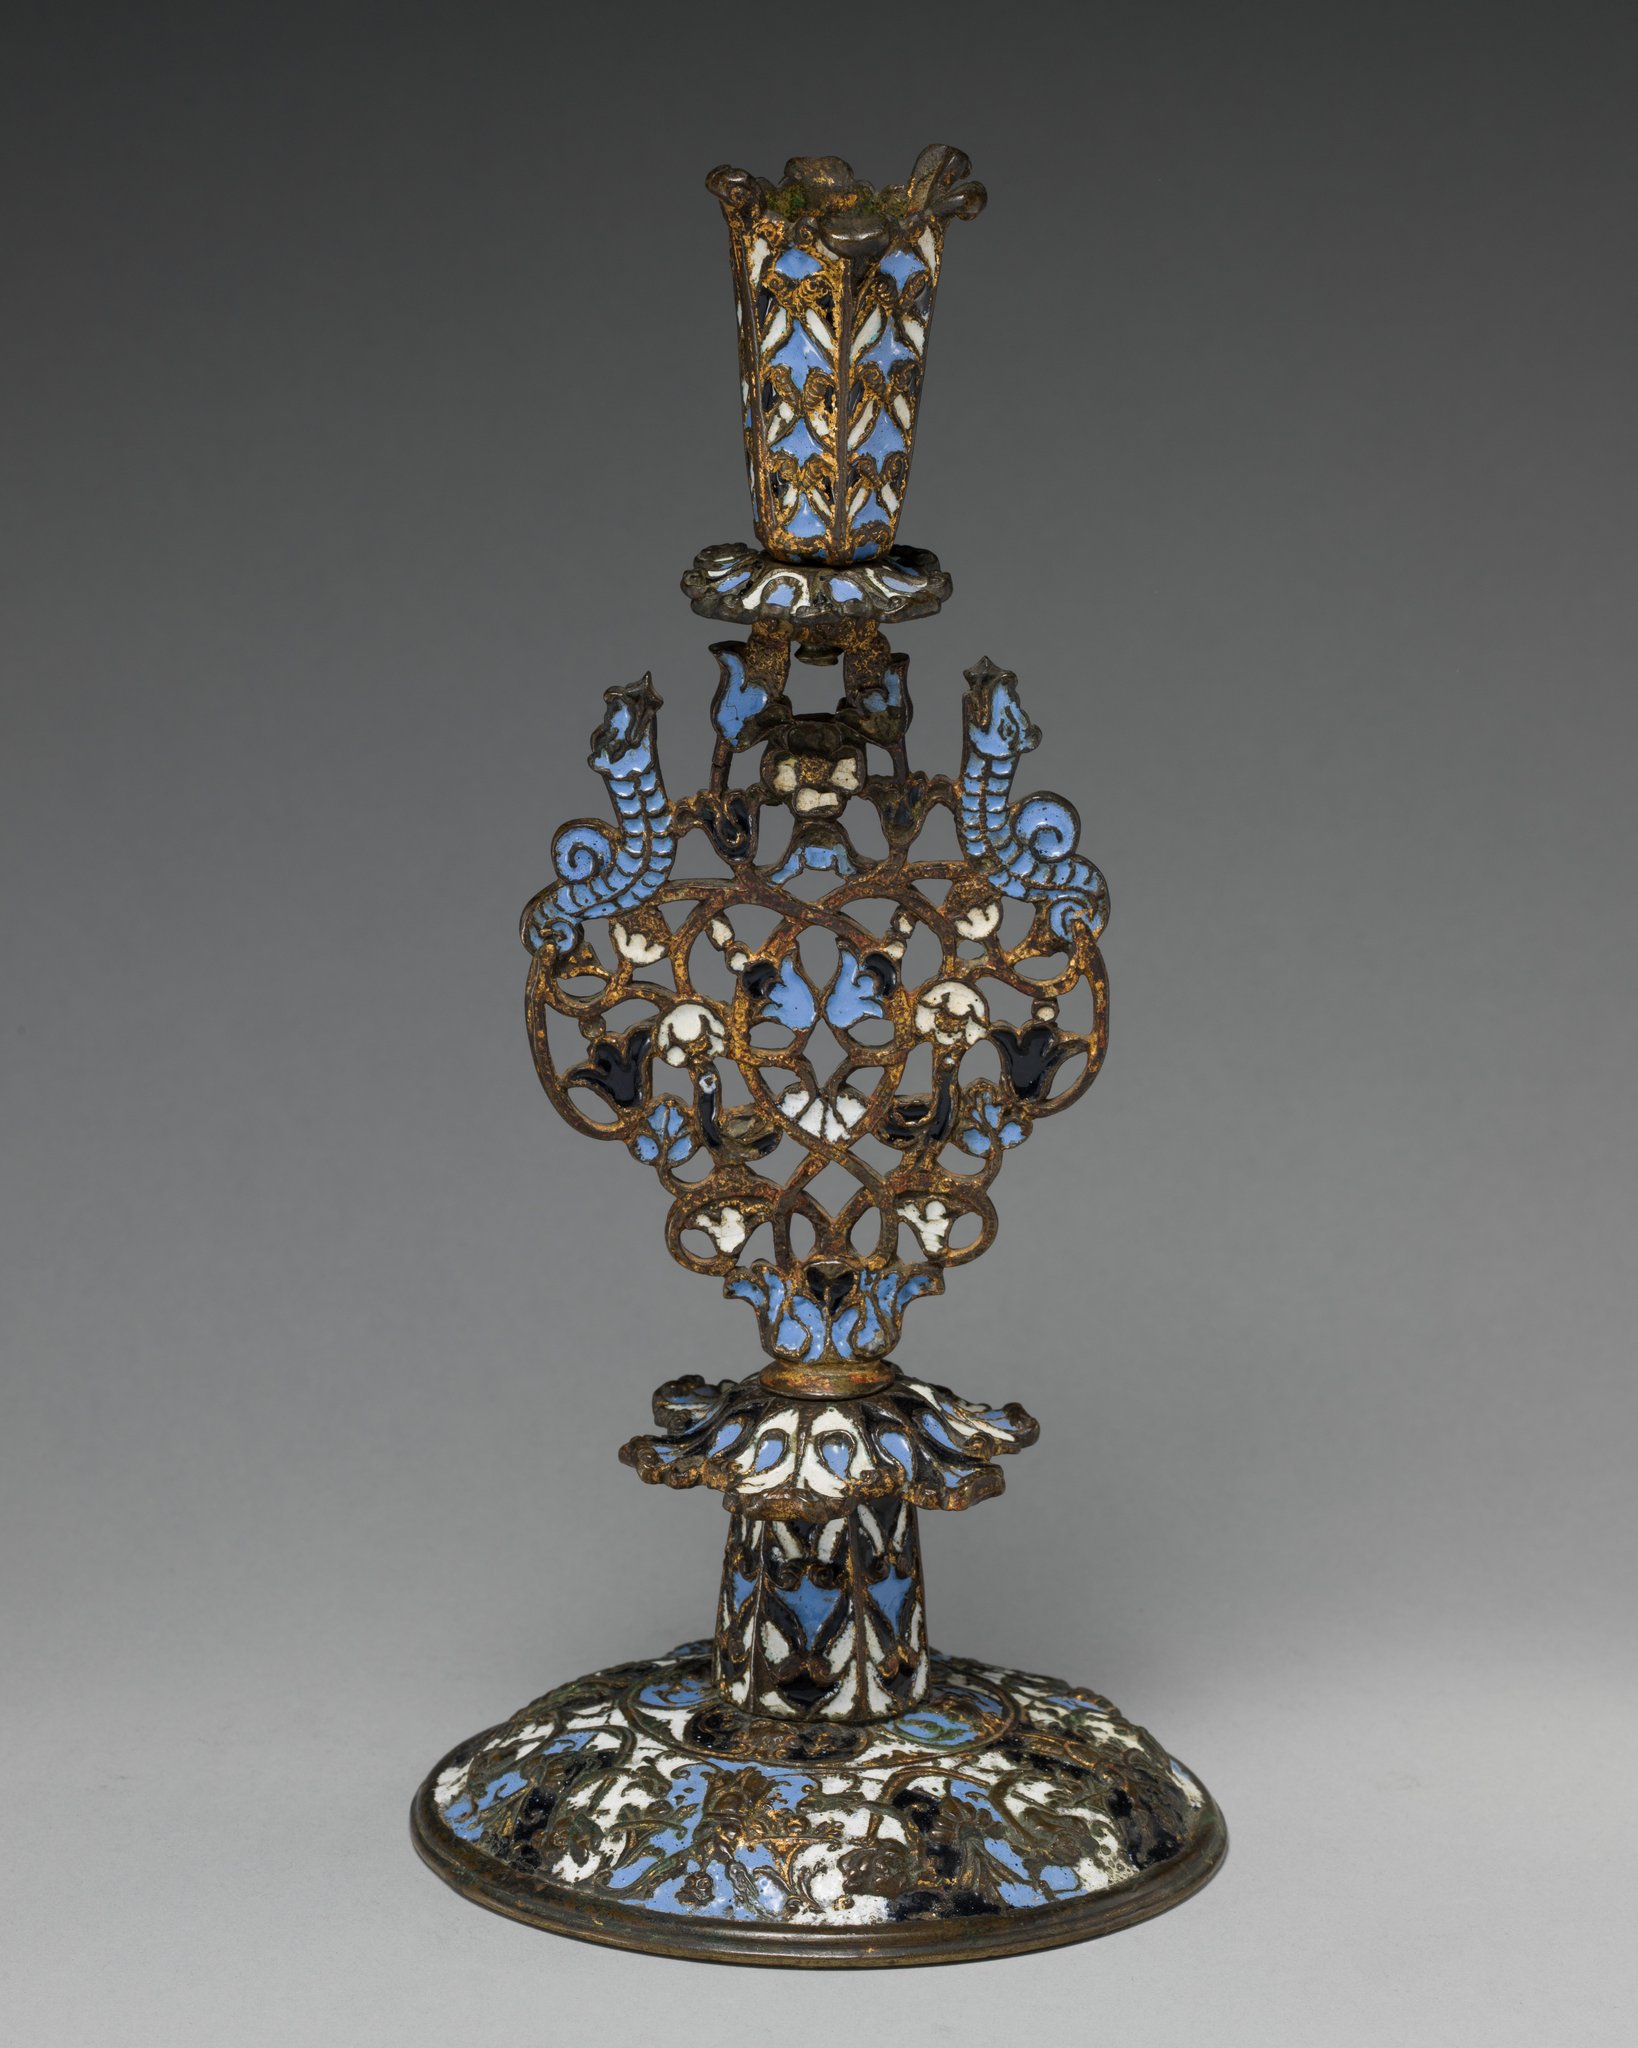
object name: candlestick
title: Candlestick (one of a pair)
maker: stephen pilcherd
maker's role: maker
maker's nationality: british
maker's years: 1570-1670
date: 1660-1680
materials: brass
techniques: enamel, gilding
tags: dragons